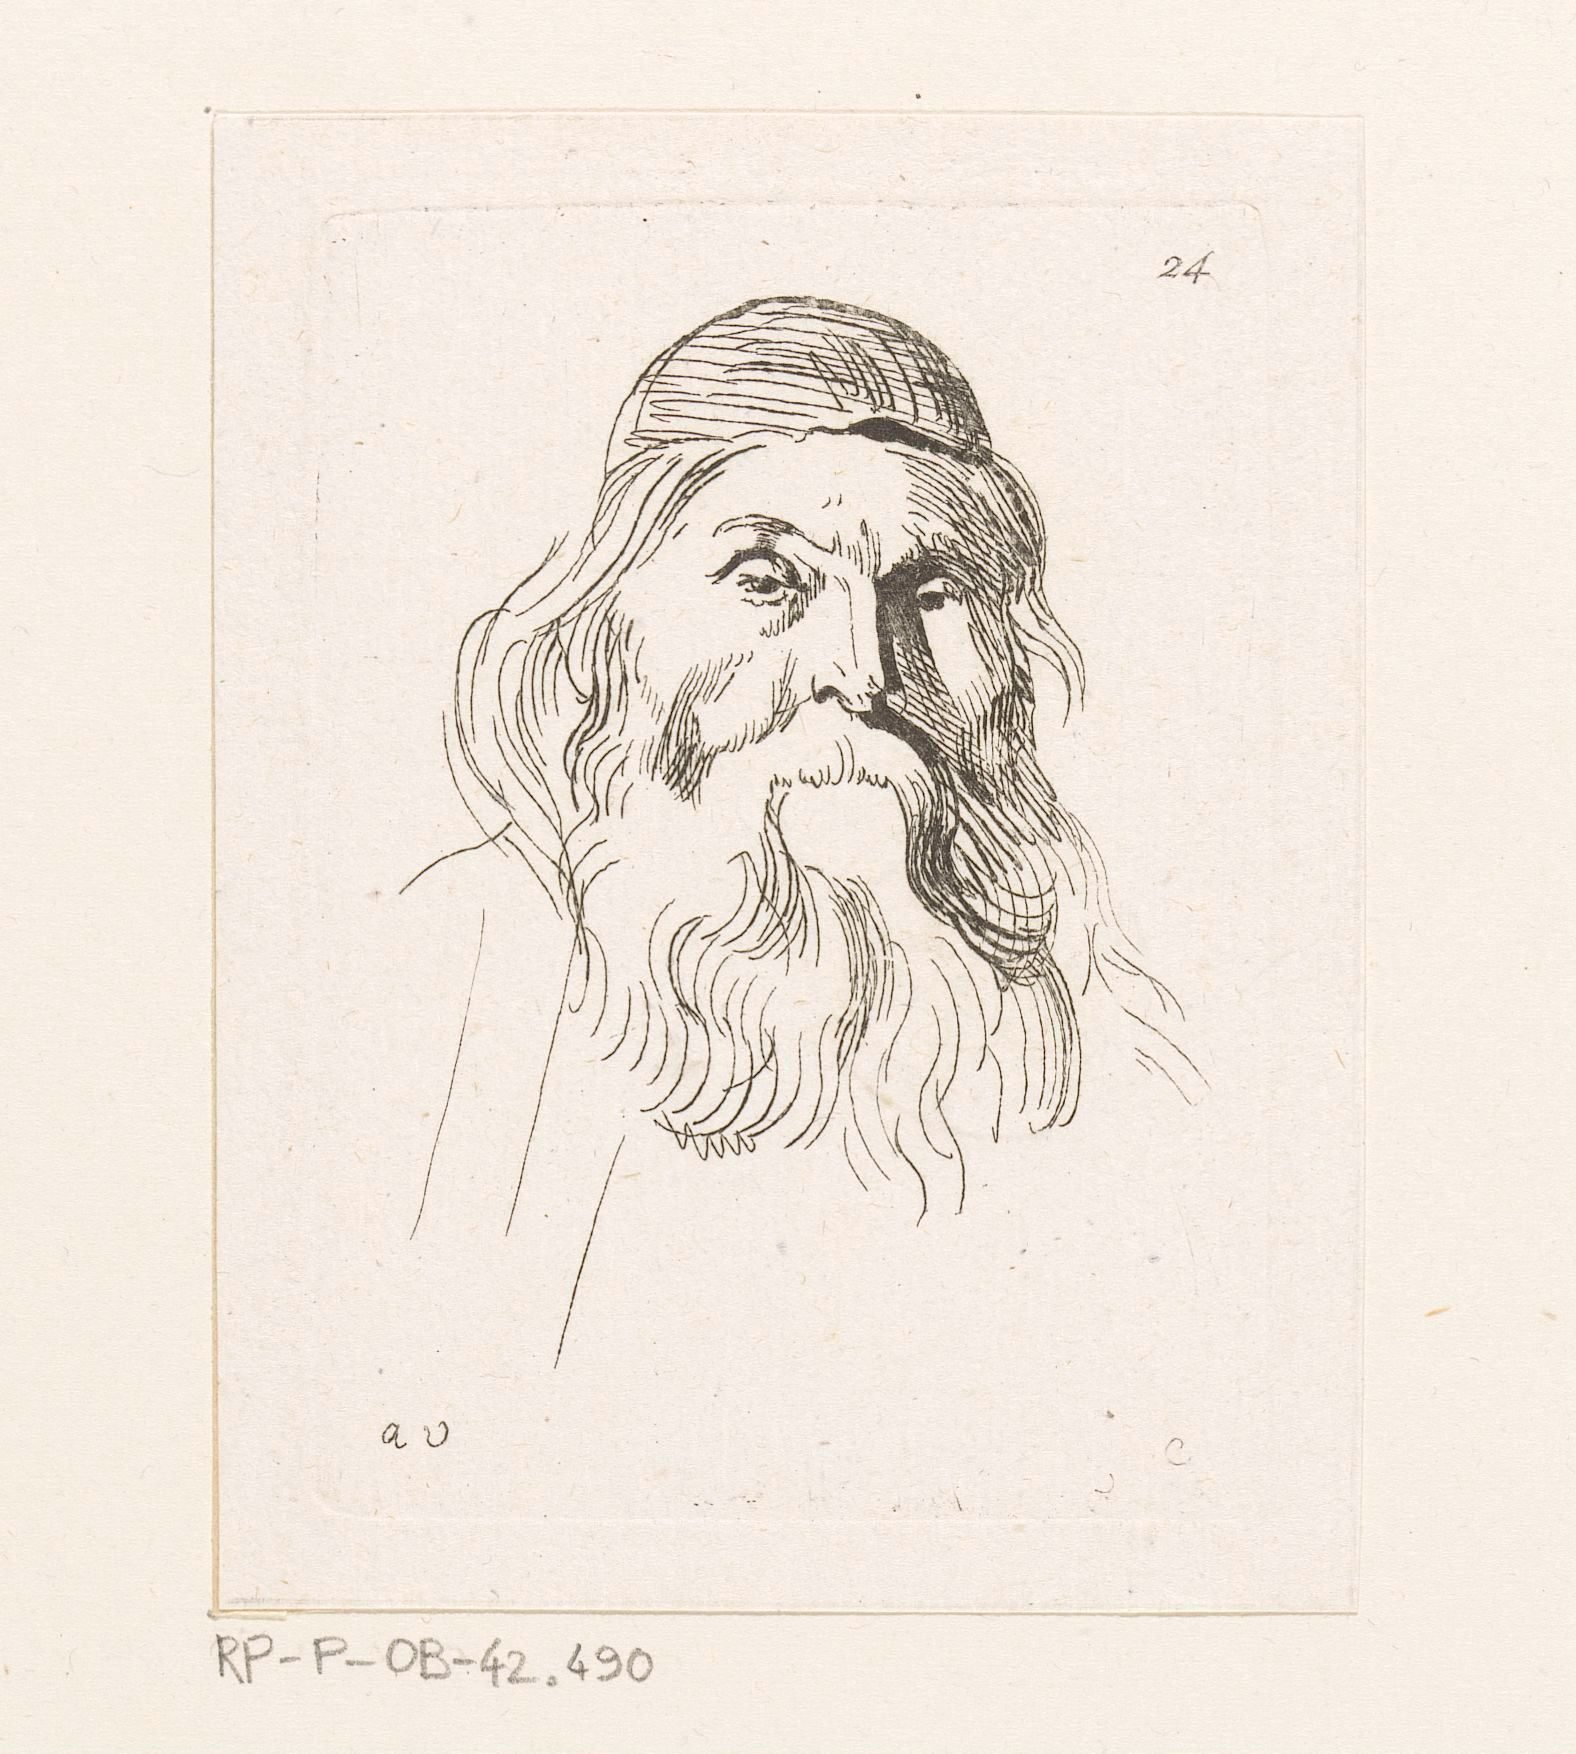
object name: print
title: Recueil de Testes d'Antoine Van Dyck (...)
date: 1735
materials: paper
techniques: etching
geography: france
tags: head (human), symbols ~ judaism and jewry, beard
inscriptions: collector's mark: Lugt 240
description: Prent uit een serie van 31 prenten naar getekende hoofden door Van Dyck, plus een titelprent naar Bouchardon, getiteld: "Recueil de Testes d'Antoine Van Dyck tirées du Cabinet de M. Crozat et gravées par M. le C. de C.".